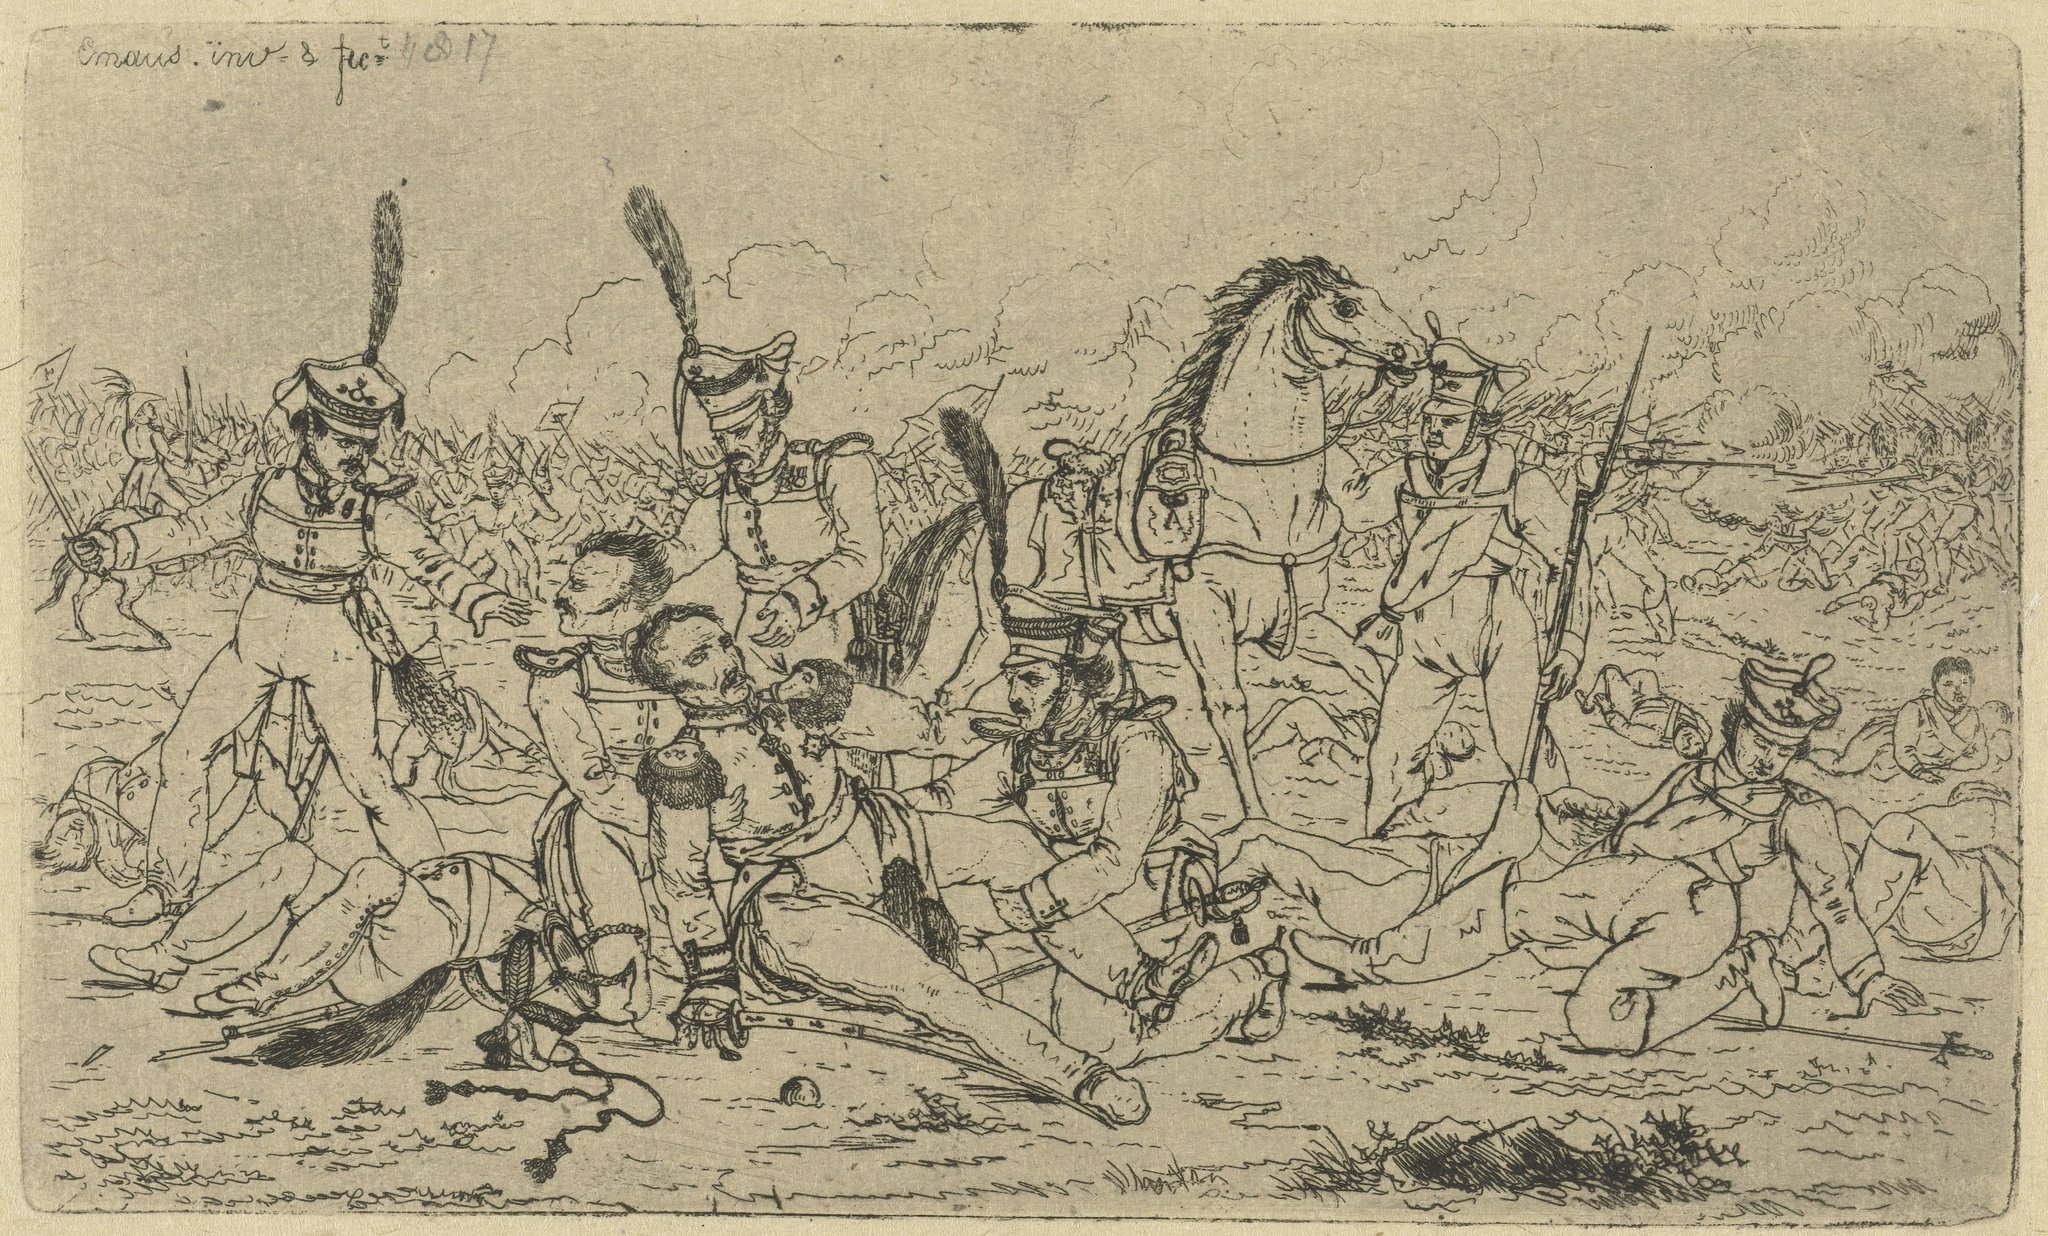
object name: print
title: Gesneuvelde generaal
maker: gerardus emaus de micault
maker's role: draughtsman, print maker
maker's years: 1798-1863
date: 1814-1863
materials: paper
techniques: etching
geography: netherlands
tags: battle (+ cavalry, horsemen)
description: Een van zijn paard gevallen generaal wordt geholpen door zijn mannen. Op de achtergrond is een veldslag gaande.